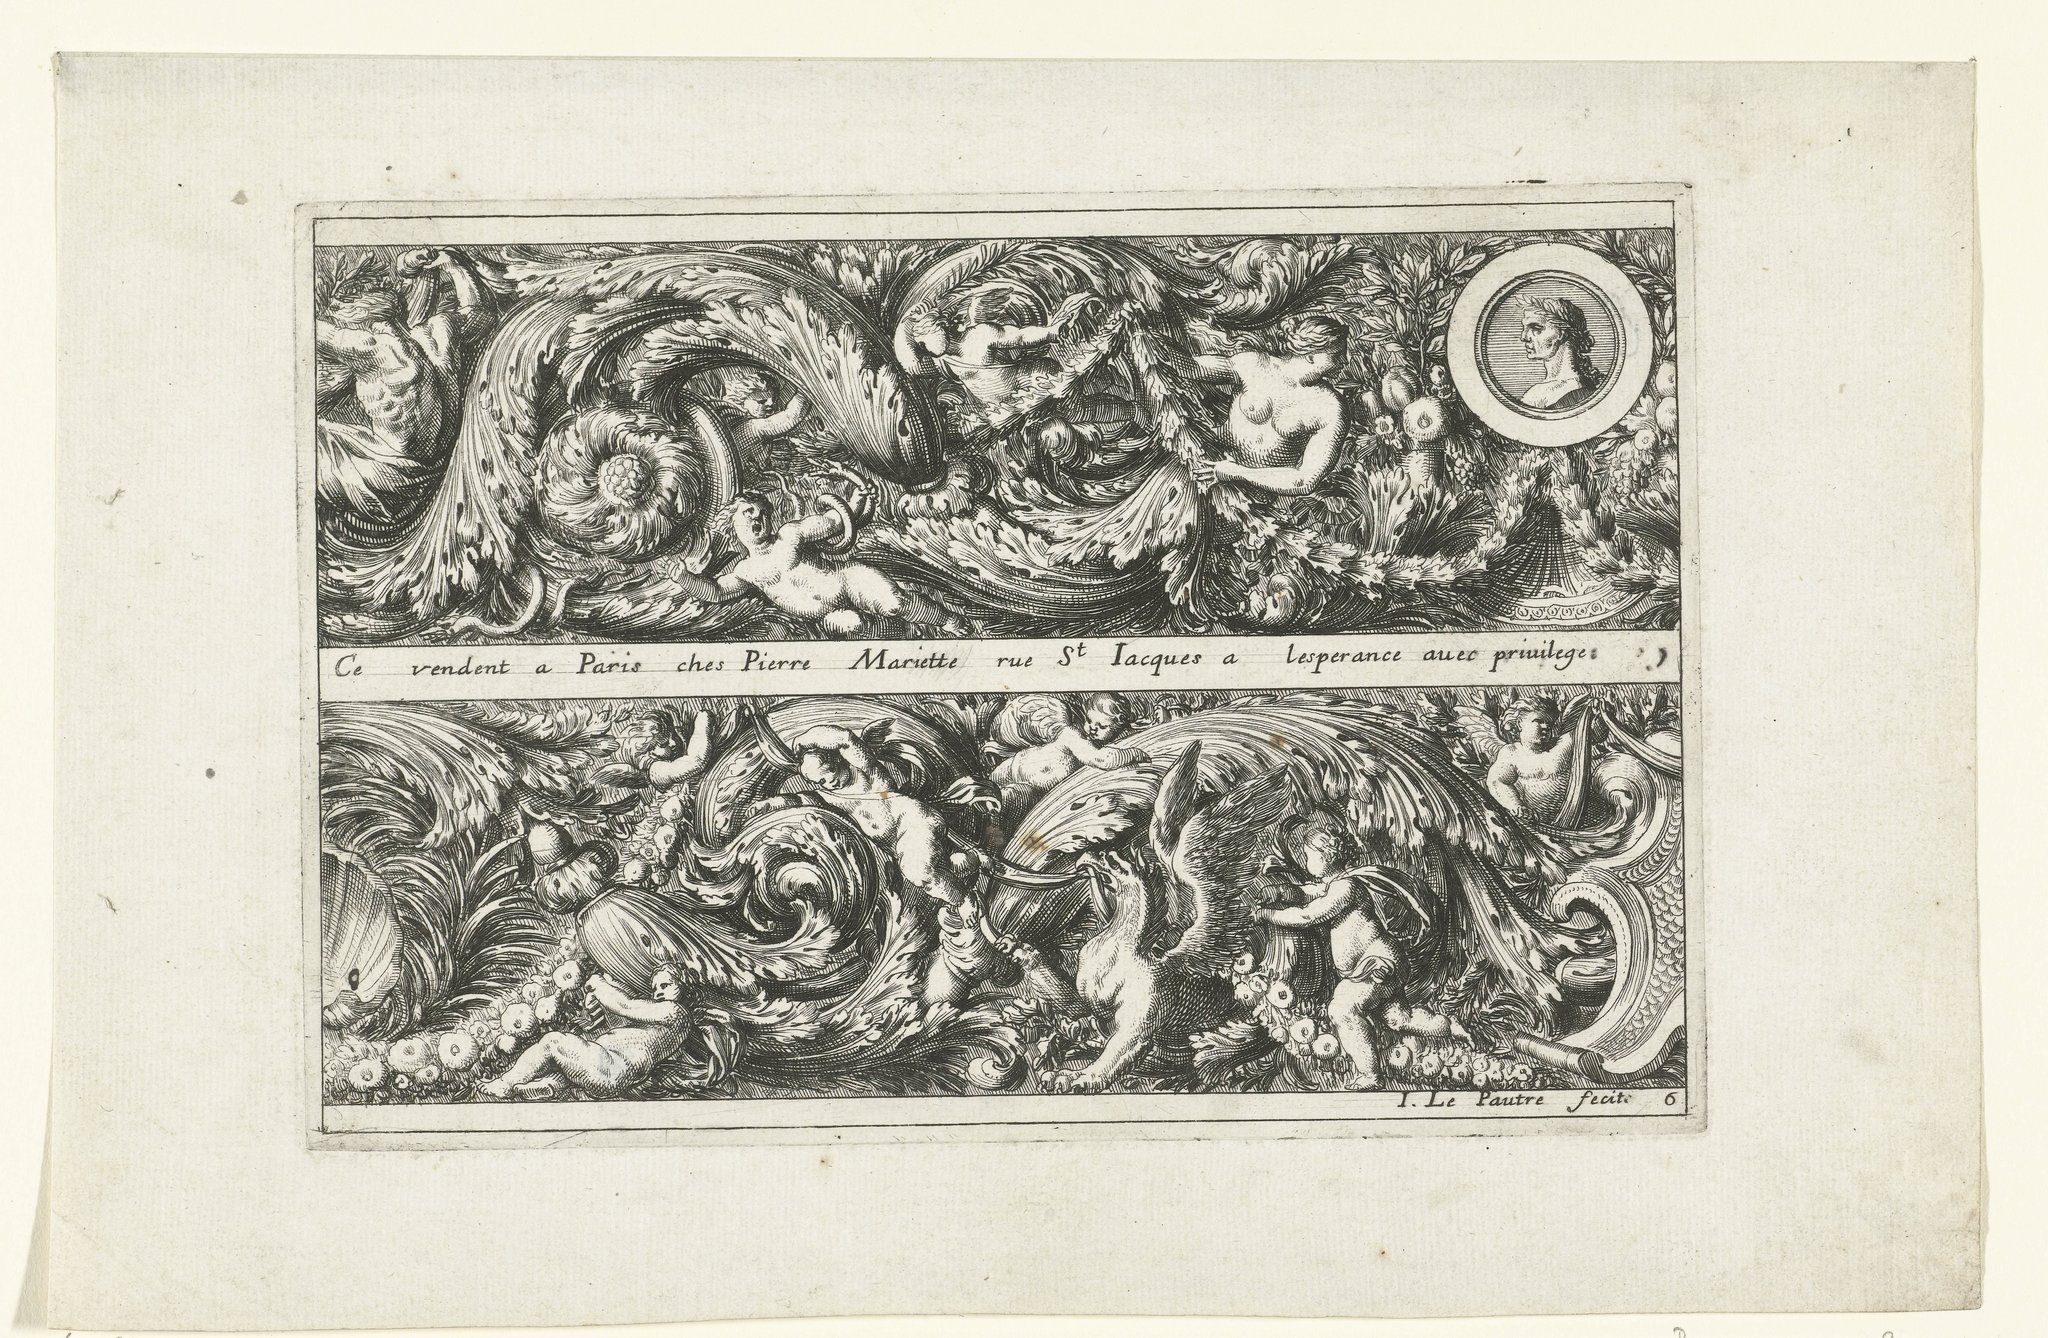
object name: ornament print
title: Frizes, feuillages ou tritons marins antiques et modernes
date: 1664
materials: paper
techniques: etching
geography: france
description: In het onderste fries spelen putti met een griffioen tussen een zware acanthusrank.